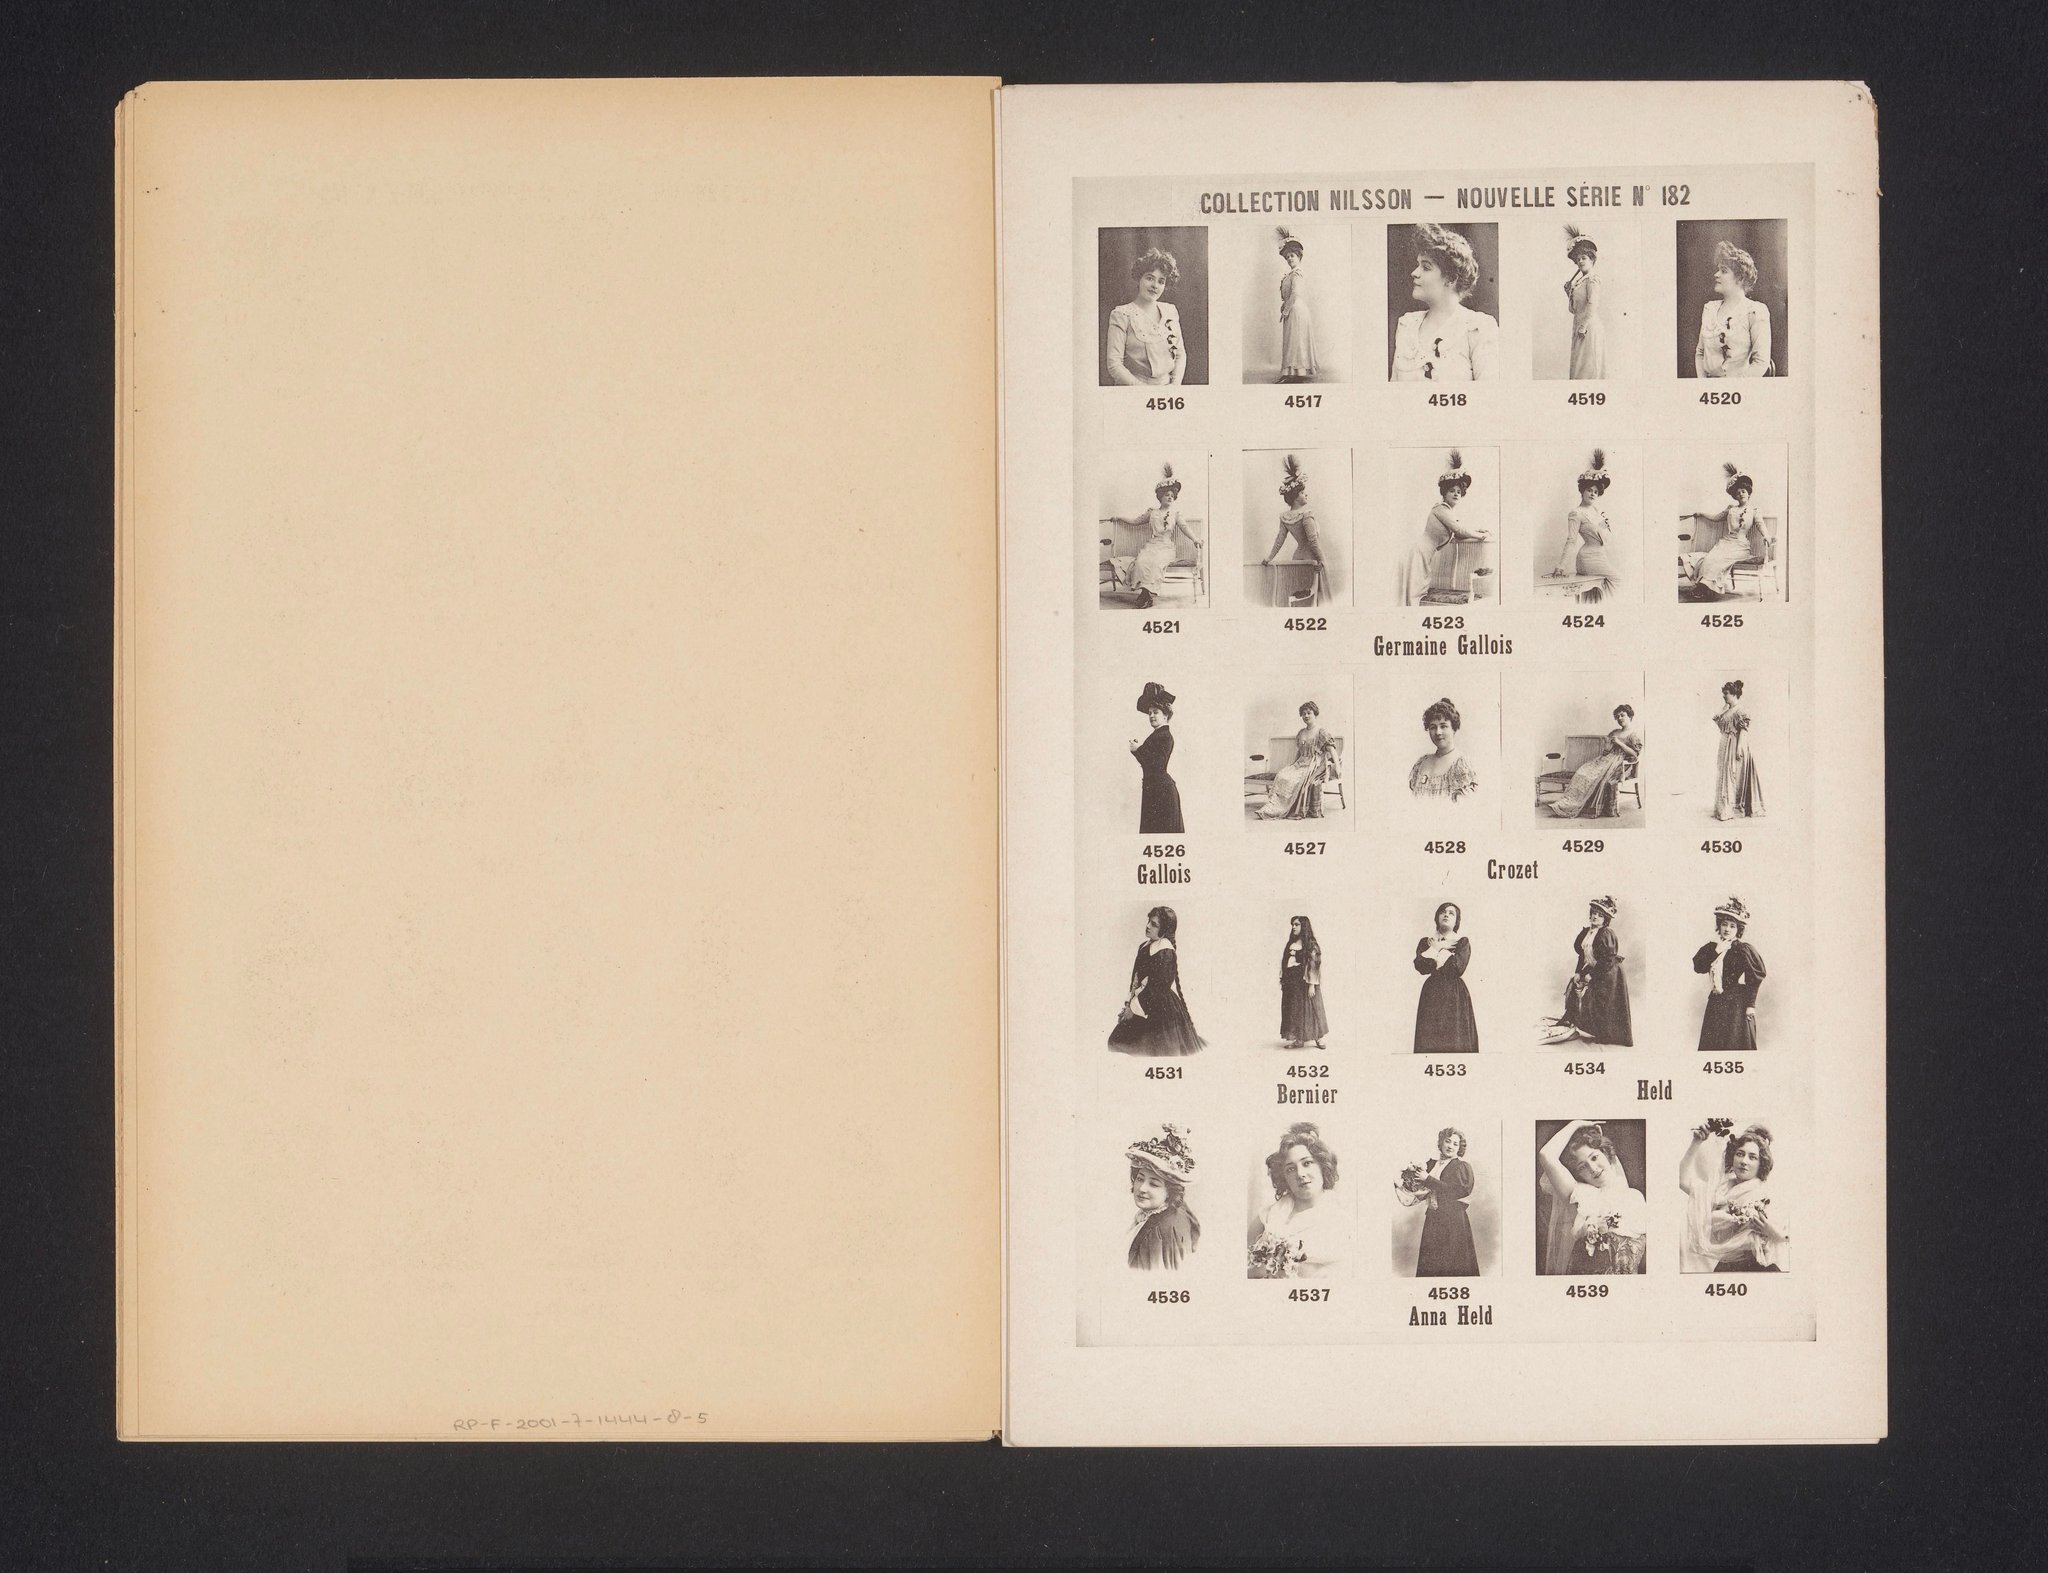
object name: photomechanical print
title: 25 portretten van Germaine Gallois, Crozet, Bernier en Anna Held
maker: Anonymous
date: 1894-1899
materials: paper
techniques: photograph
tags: new york (city), historical persons - bb - woman, portrait of actor, actress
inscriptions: number: ‘No 182’